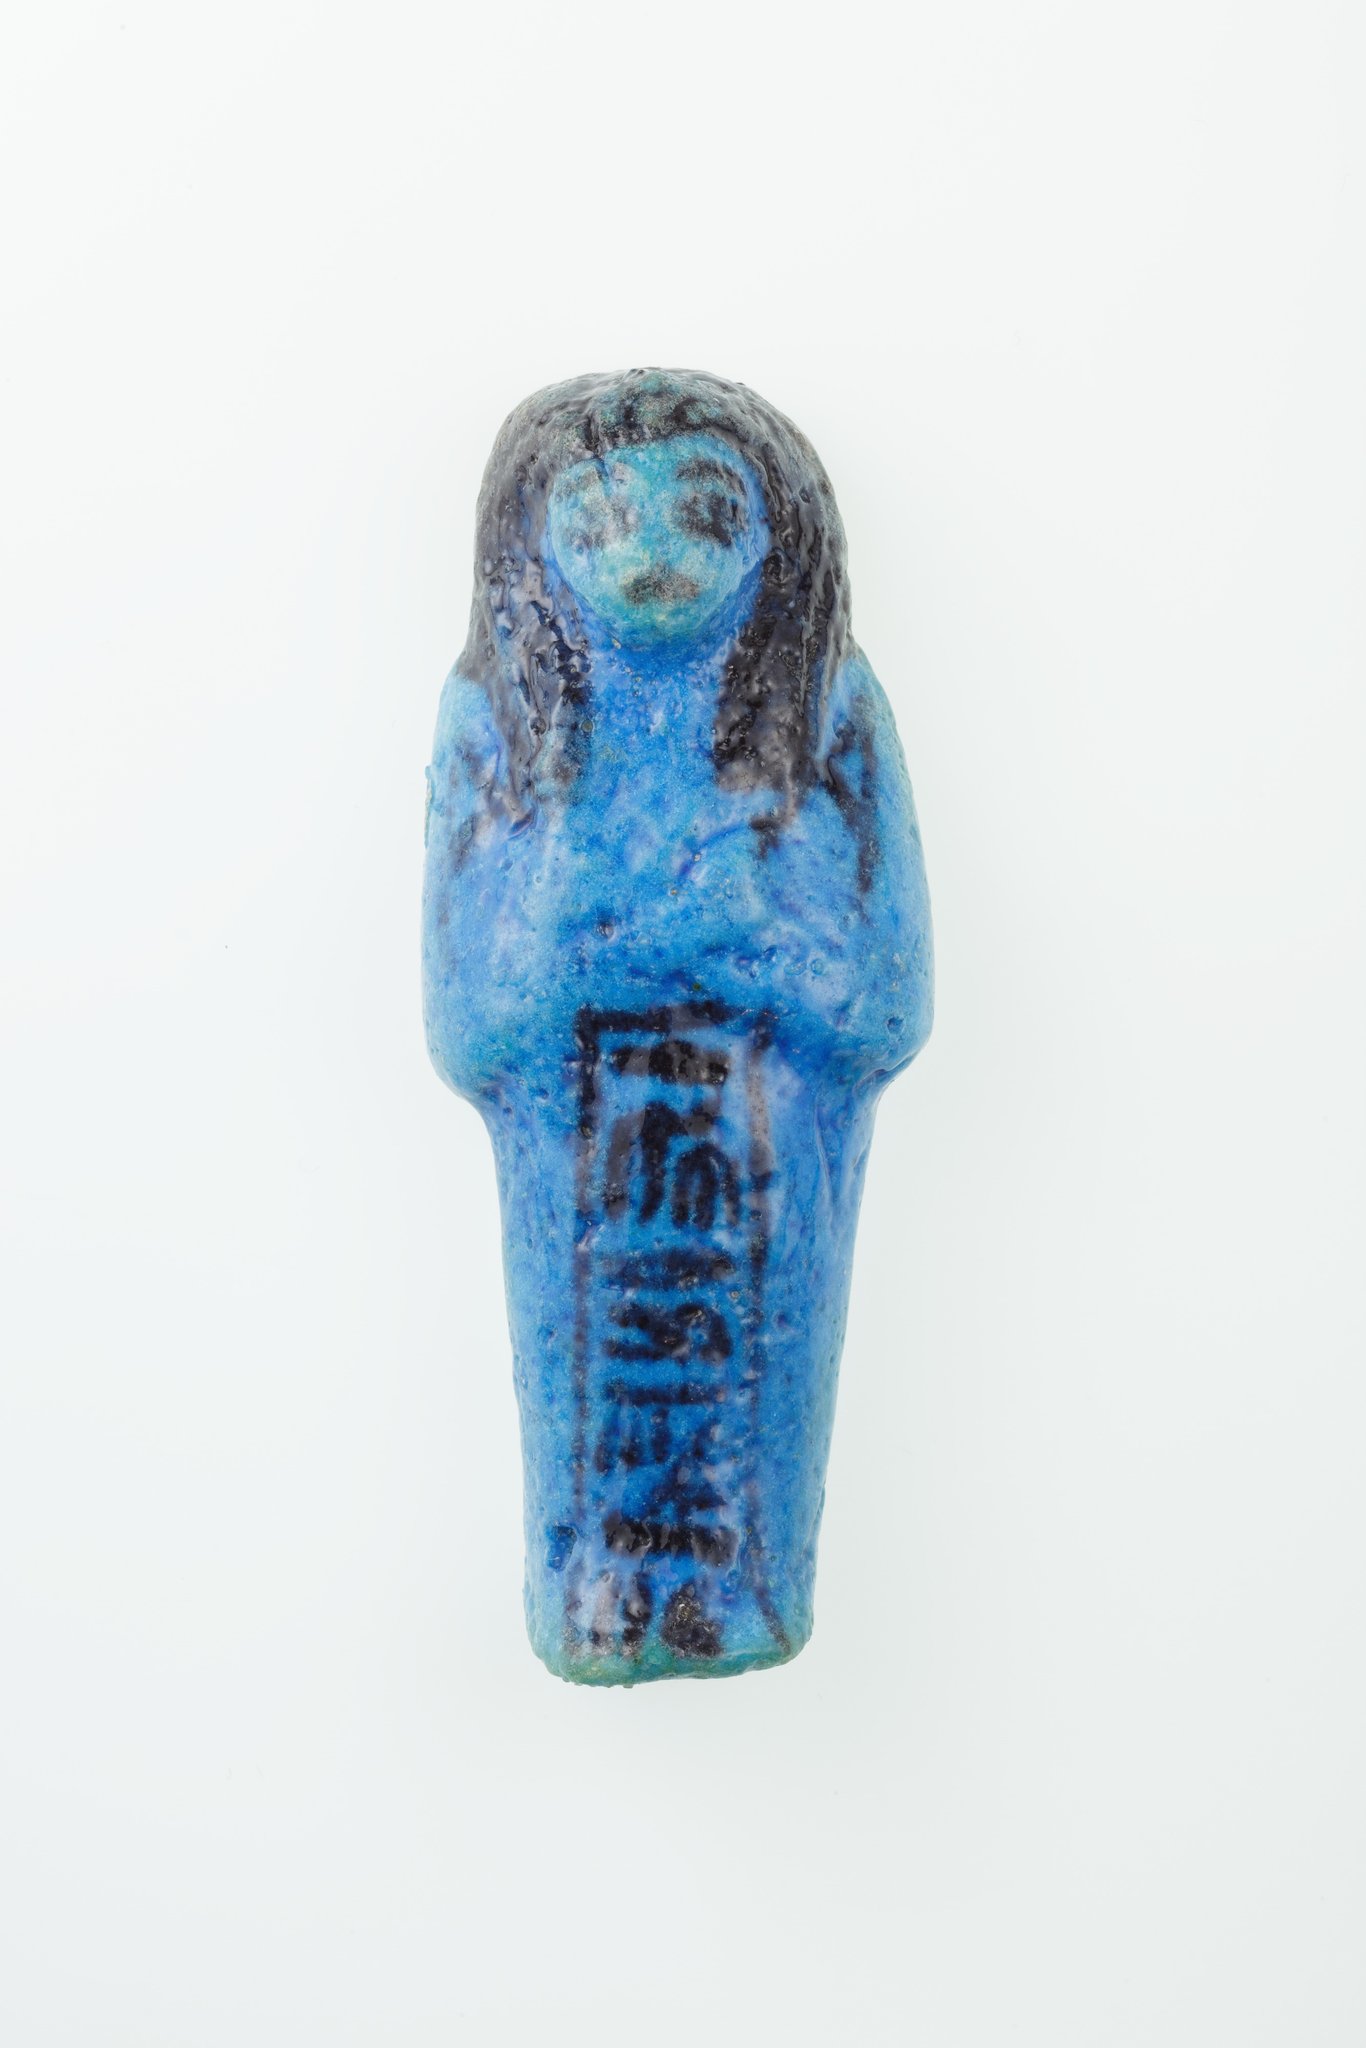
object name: shabti, worker, nauny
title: Worker Shabti of Nauny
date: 1050 BCE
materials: faience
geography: egypt